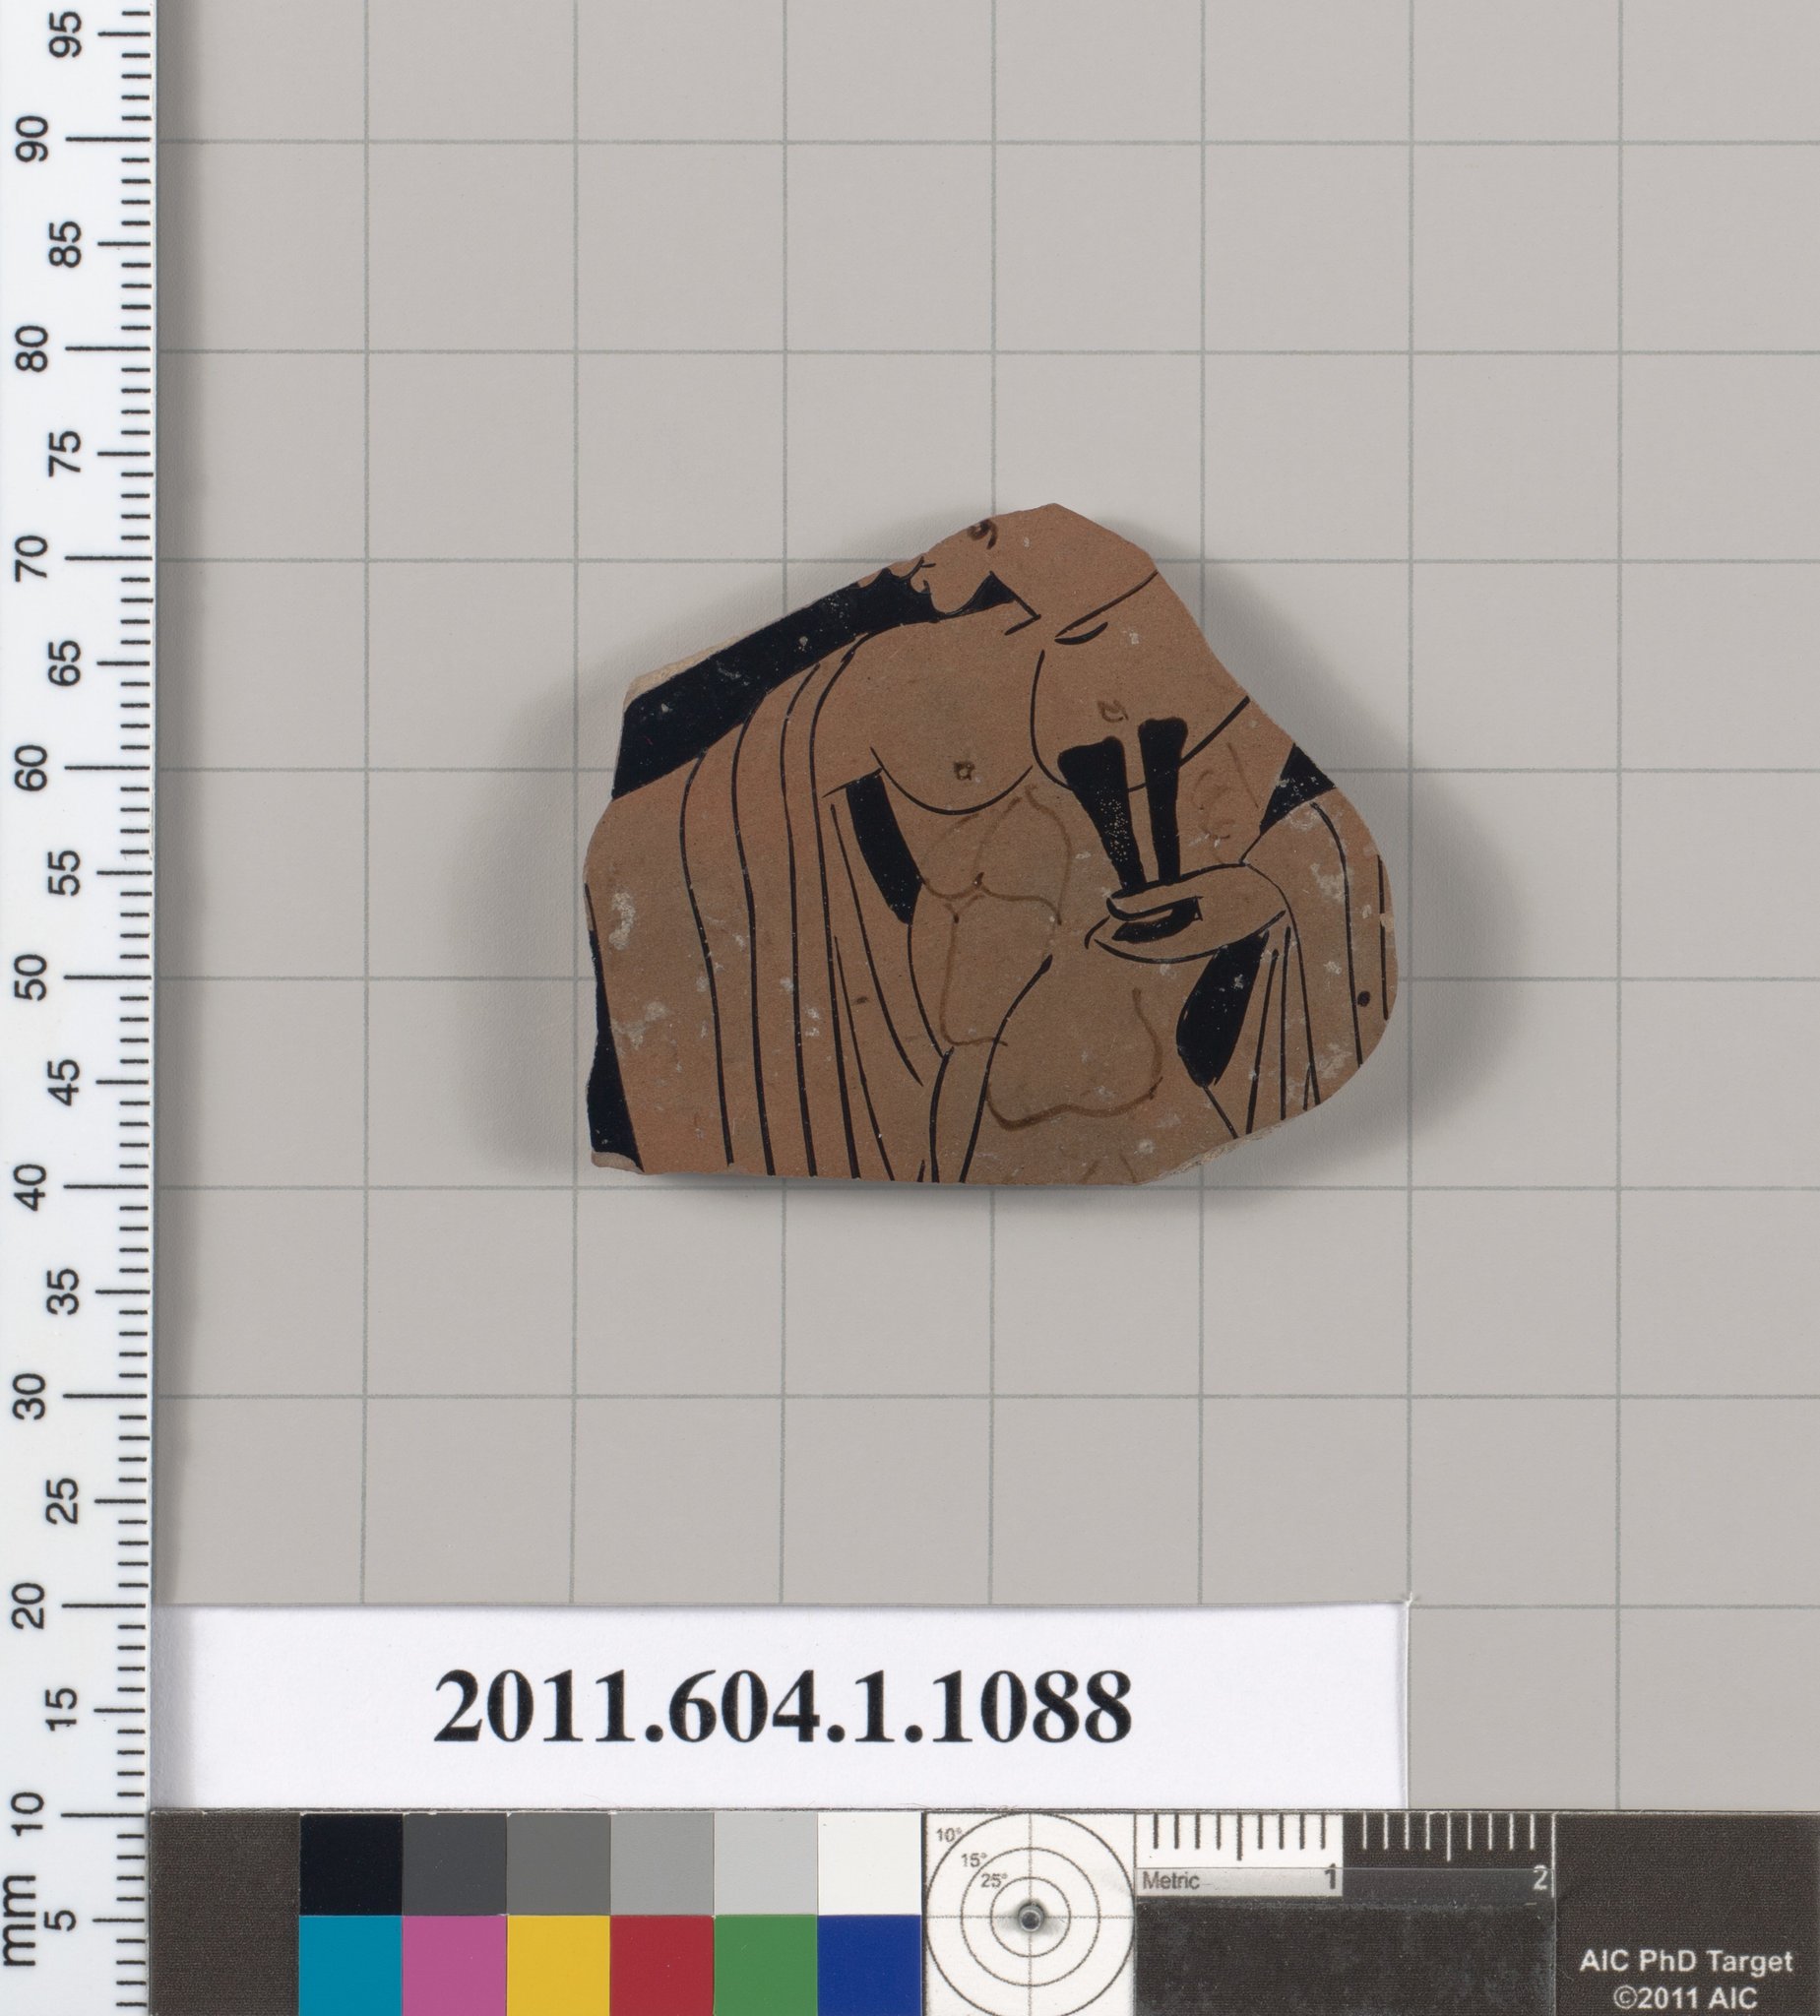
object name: kylix fragment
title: Terracotta fragment of a kylix (drinking cup)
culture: greek, attic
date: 490-480 BCE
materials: terracotta